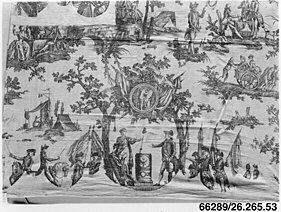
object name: furnishing textile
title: "Fête de la Fédération"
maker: jean-baptiste huet i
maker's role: designer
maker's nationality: french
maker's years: 1745-1811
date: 1793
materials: linen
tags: tents,battles,men